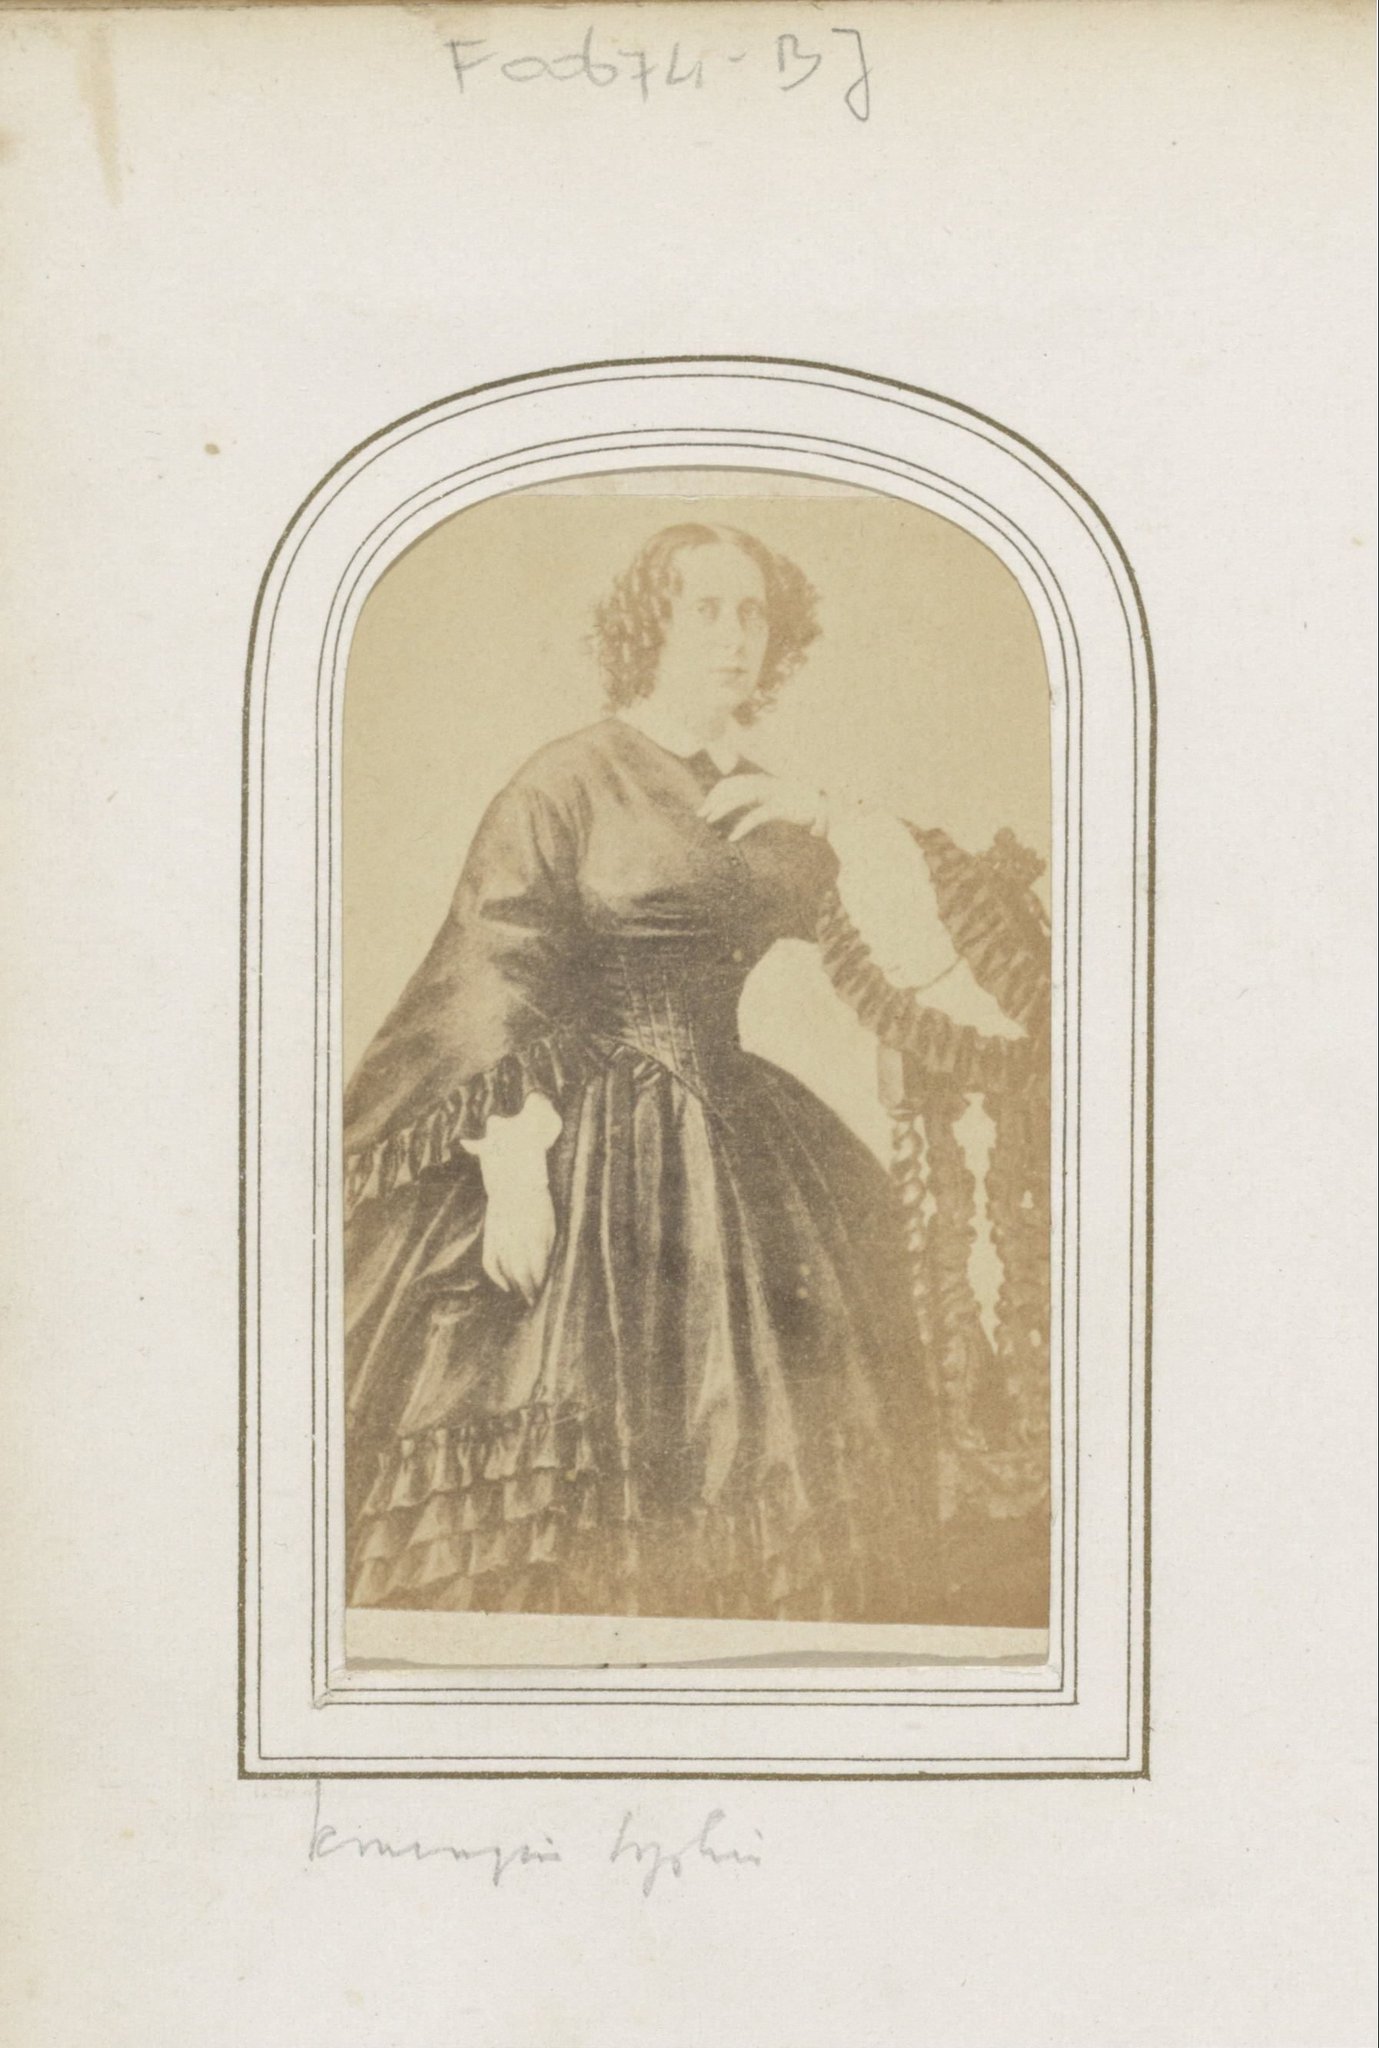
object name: photograph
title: Portret van Sophia van Württemberg ('Sophie'), koningin der Nederlanden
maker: Anonymous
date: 1855-1860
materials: cardboard, paper, photographic support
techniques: albumen print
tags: the hague, sophia frederika mathilda van württemberg, studio requisites ~ photographer, historical persons, styles of hairdress - aa - ~ women, ruler, sovereign, dress, gown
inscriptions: negative number: ‘1105’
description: Onderdeel van Fotoalbum met 123 cartes-de-visite van leden van Europese vorstenhuizen, politici en bekende personen.